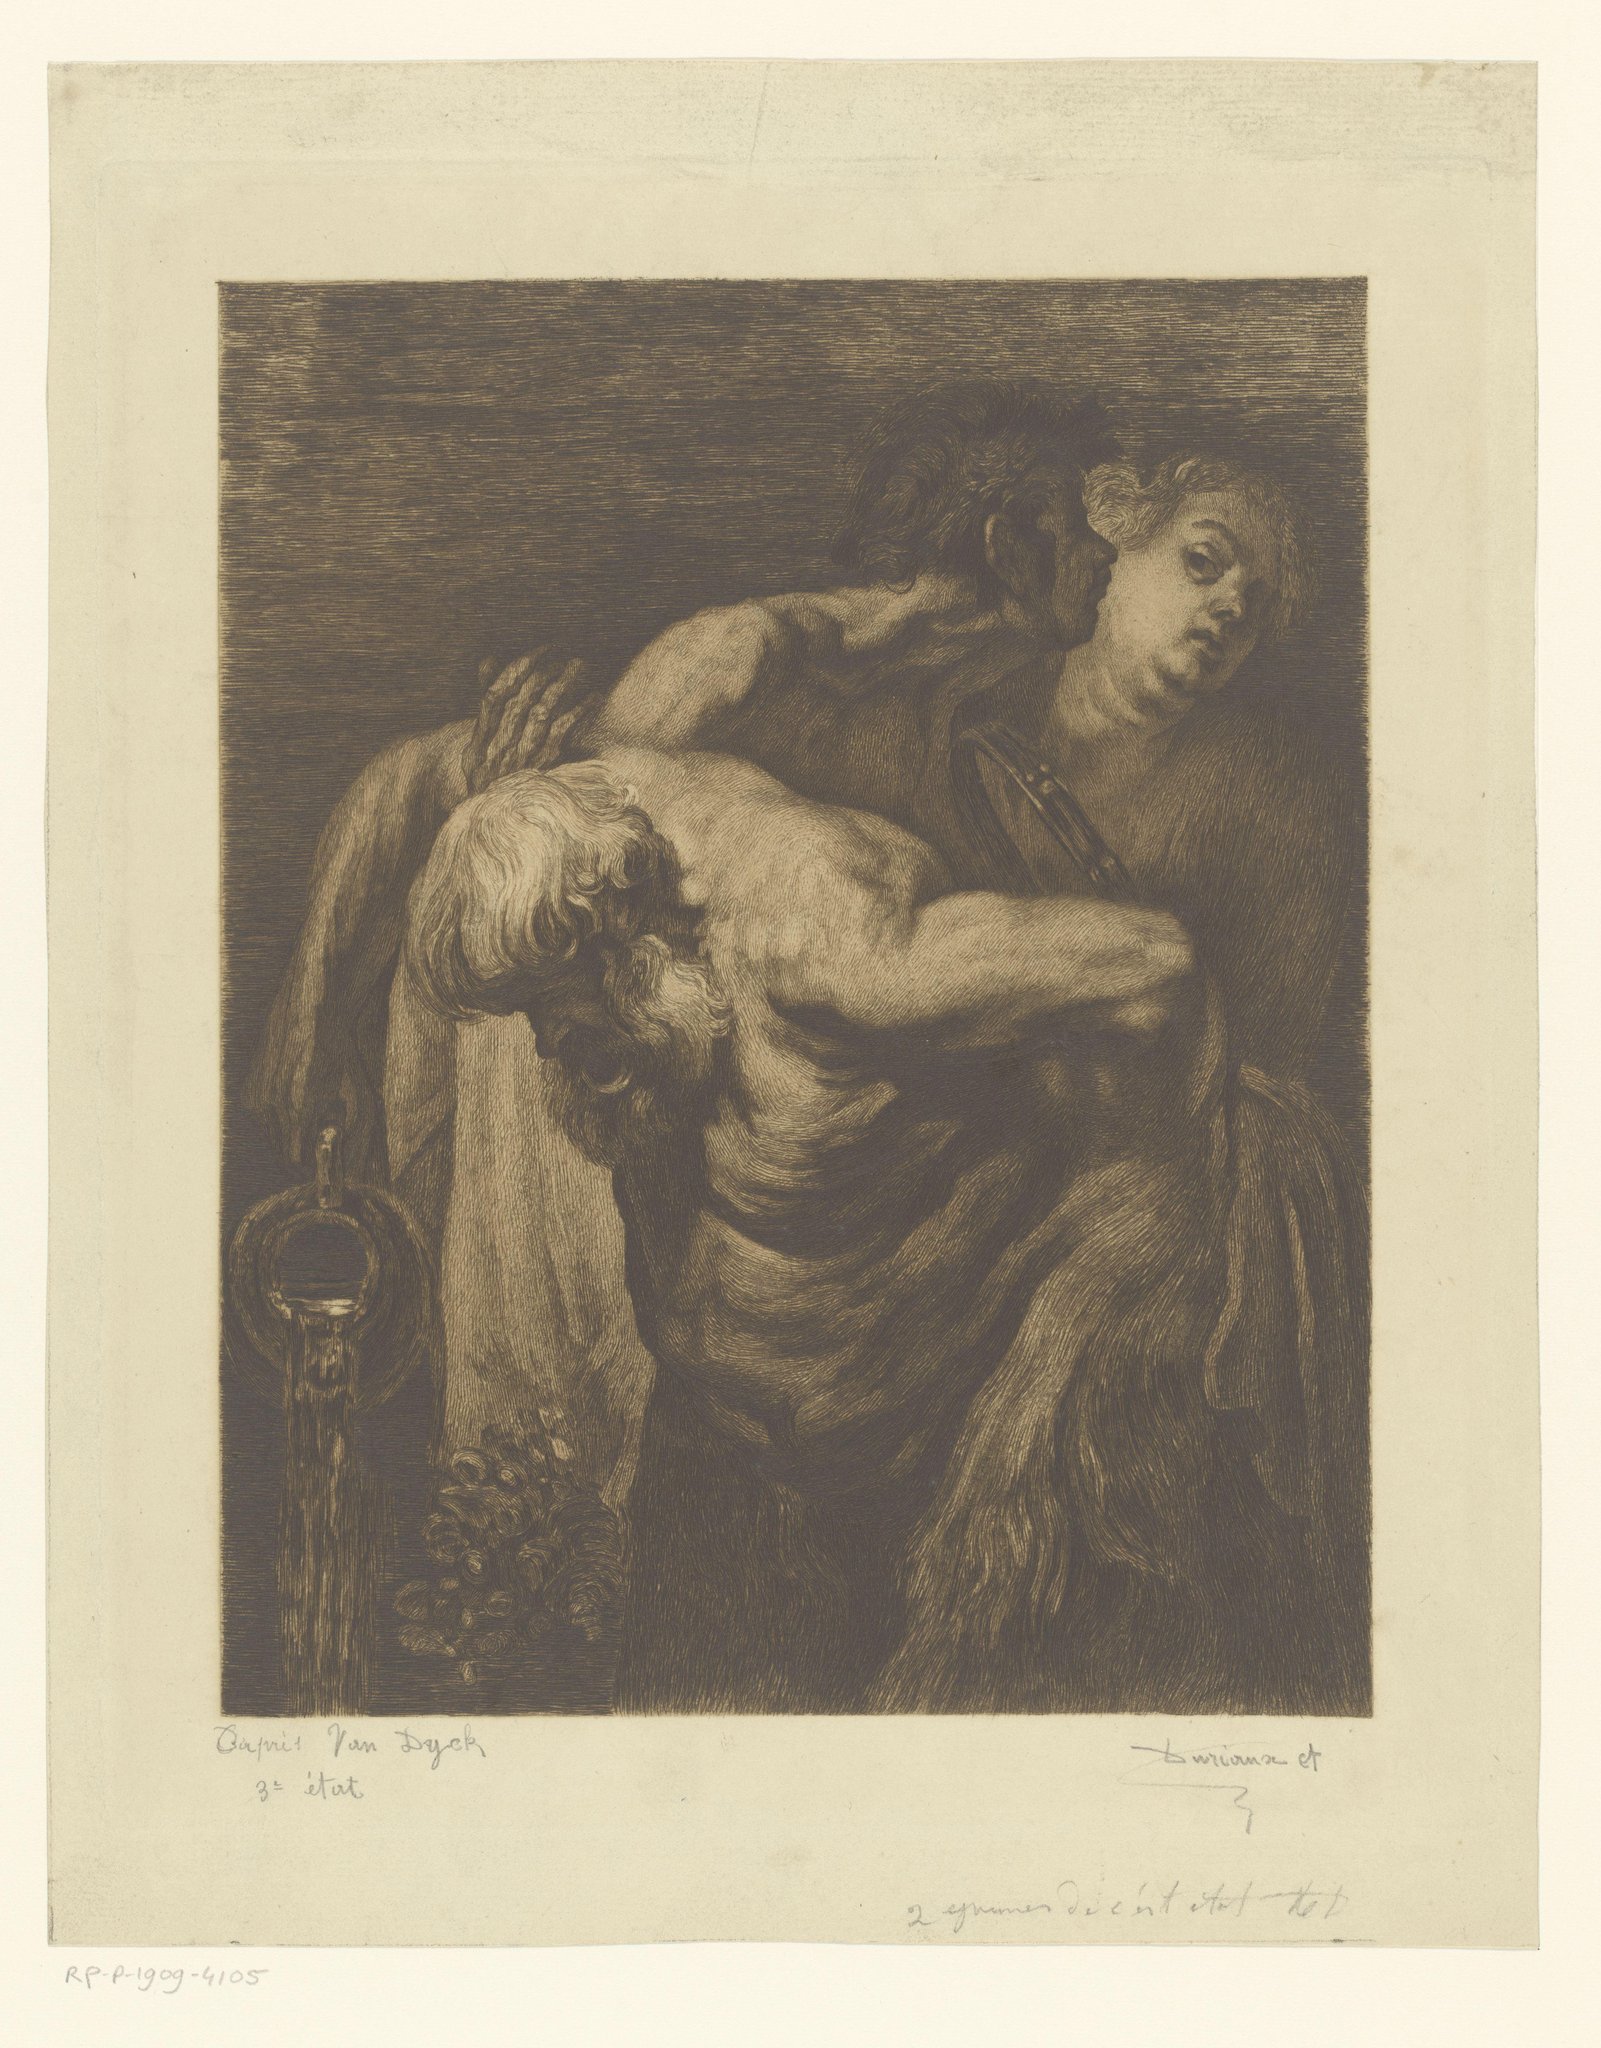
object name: print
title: Dronken Silenus met twee bacchanten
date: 1887-1909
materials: paper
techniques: etching, intaglio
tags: (story of) silenus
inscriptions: collector's mark: Lugt 2228, inscription: ‘Daprès Van Dyck; 3e état; 2 epreuves de c'est etat AD’